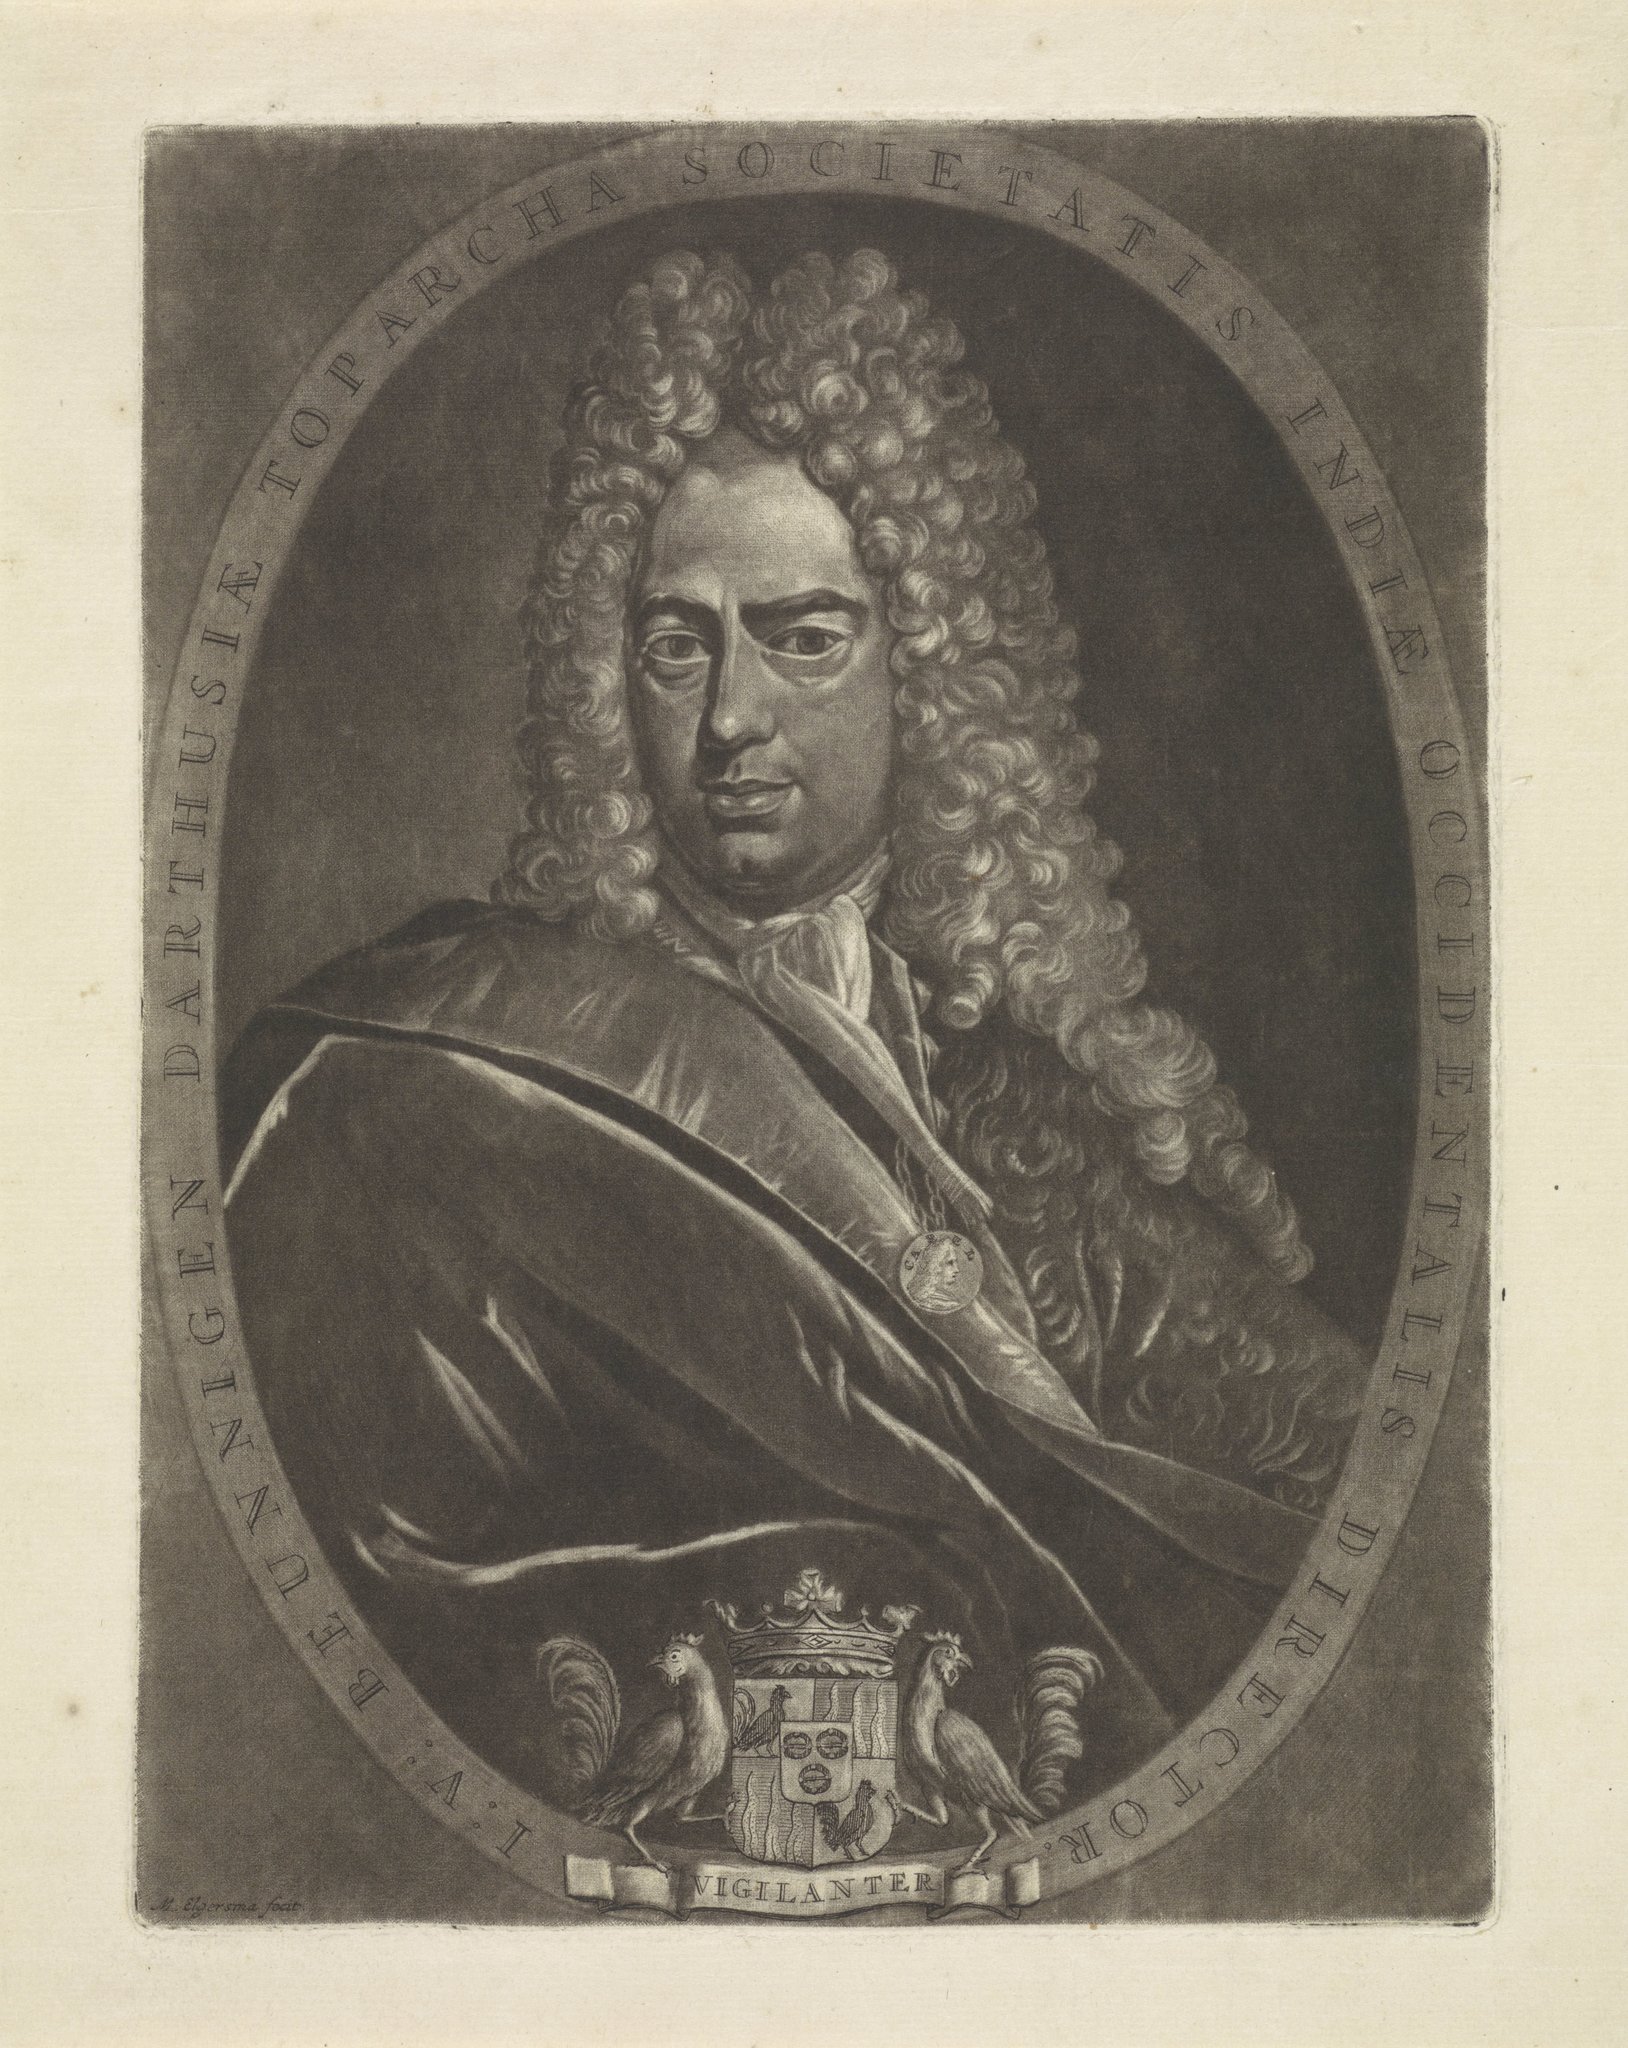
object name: print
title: Portret van Jan van Beuningen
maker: michiel elgersma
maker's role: print maker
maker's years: 1690-1759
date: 1714-1759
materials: paper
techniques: engraving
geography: amsterdam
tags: jan van beuningen, wig, armorial bearing, heraldry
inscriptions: collector's mark: Lugt 2228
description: Portret van de schrijver, koopman en bankier Jan van Beuningen. Hij was tevens gouverneur van Curaçao. Hij draagt een pruik en om de hals een keten met een medaillon. In de omlijsting zijn titels en zijn wapen.